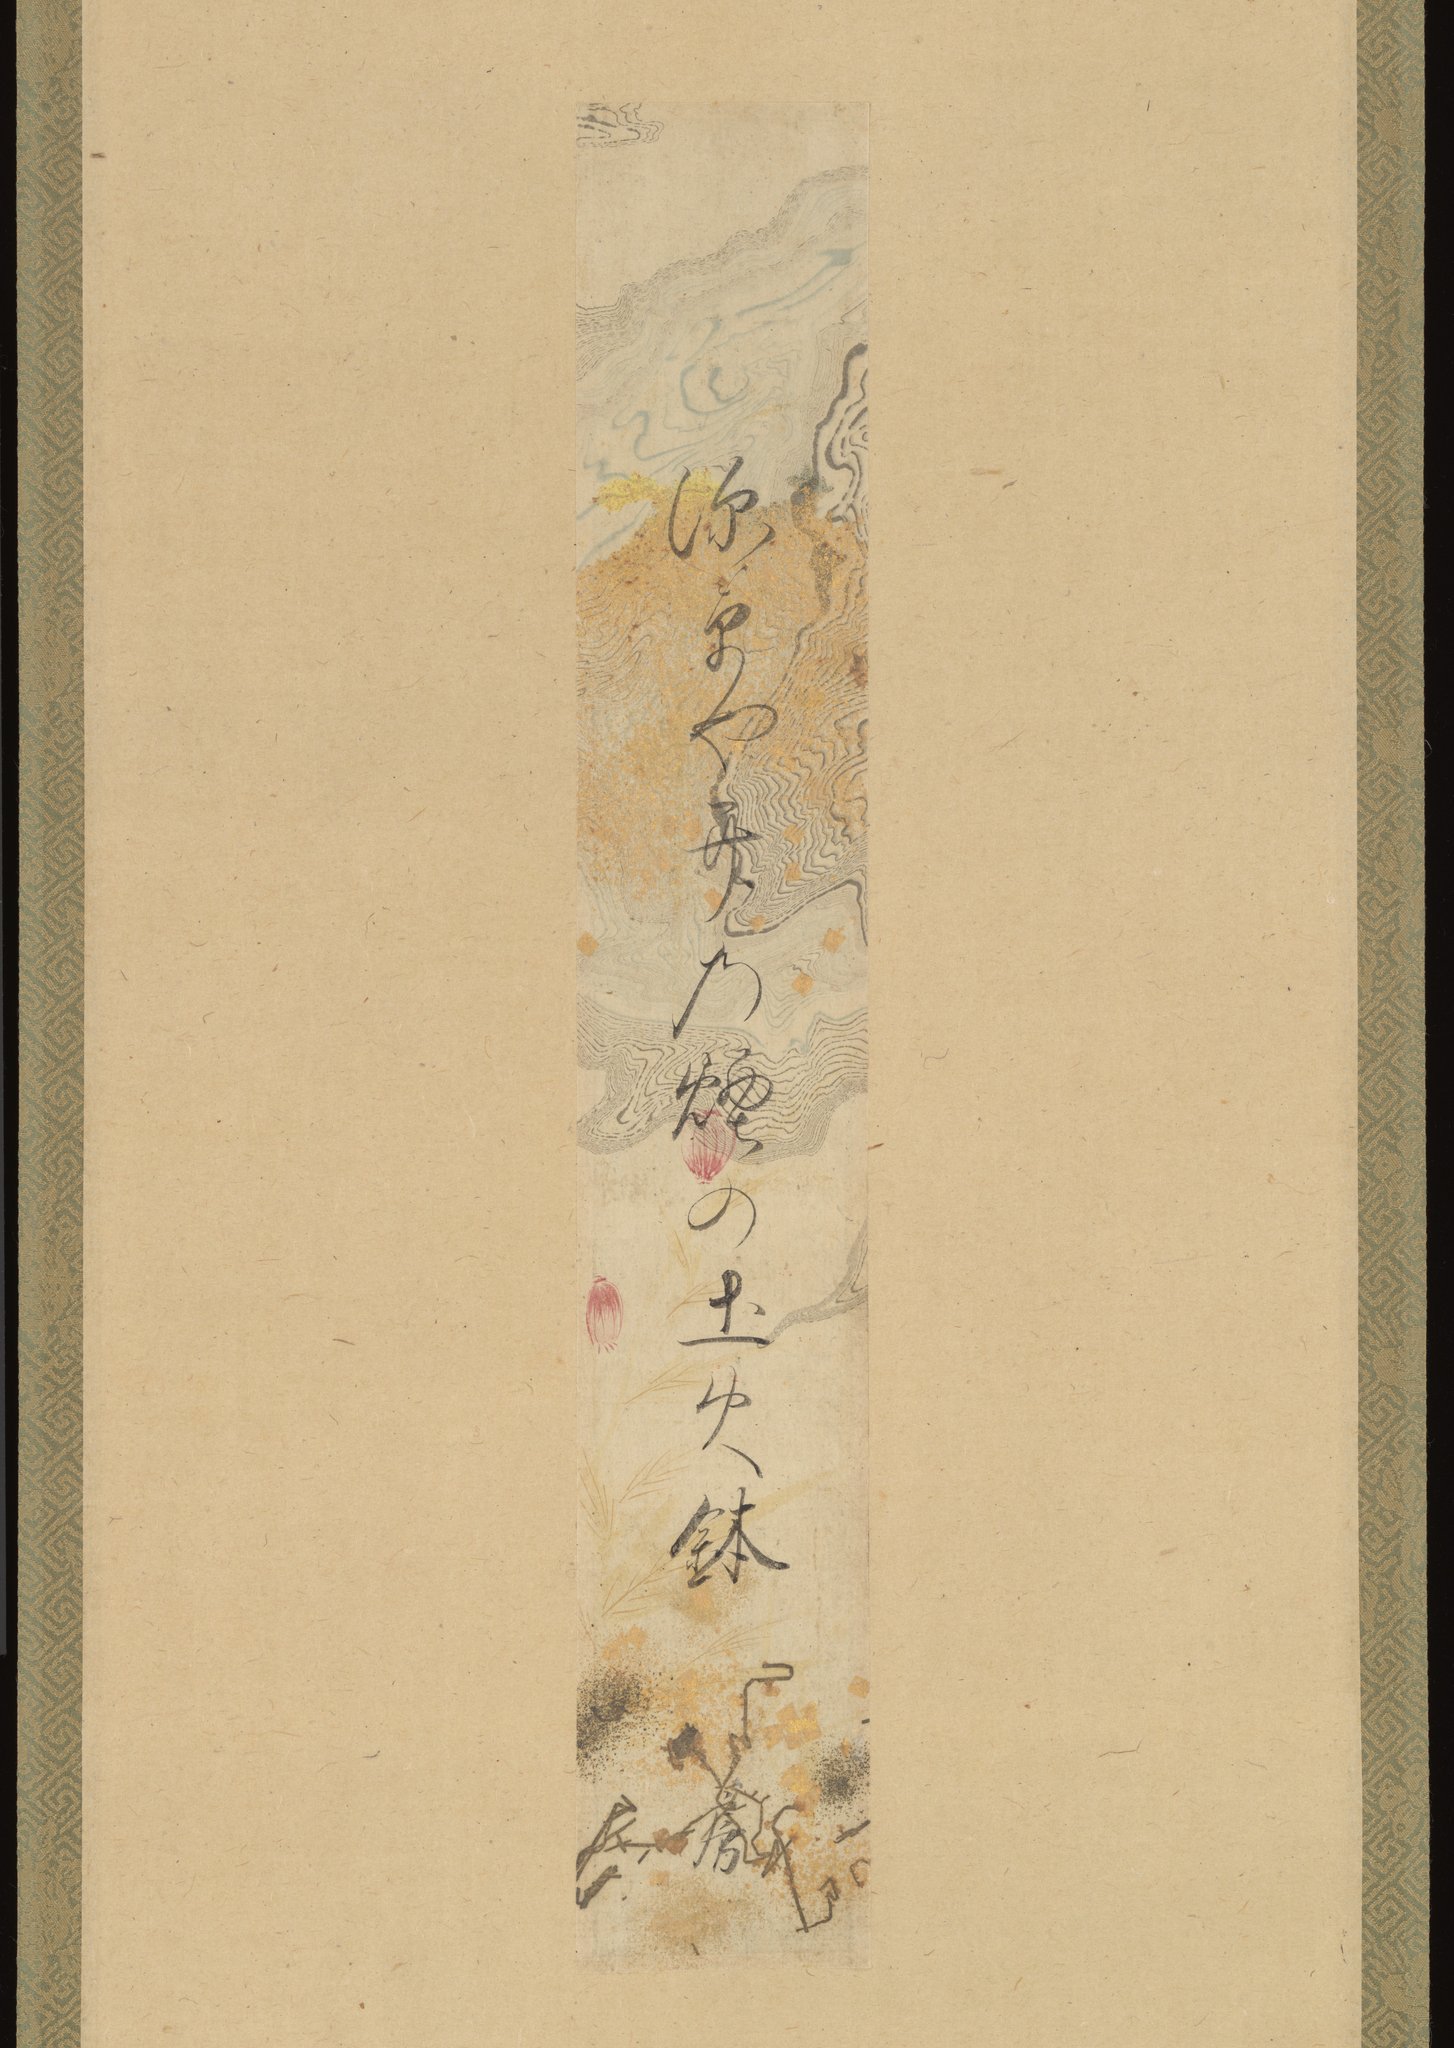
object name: hanging scroll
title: Haiku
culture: japanese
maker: iwakura tomonori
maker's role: artist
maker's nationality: japanese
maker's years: 1629-1680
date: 1629-1680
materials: gold, ink, paper, silver